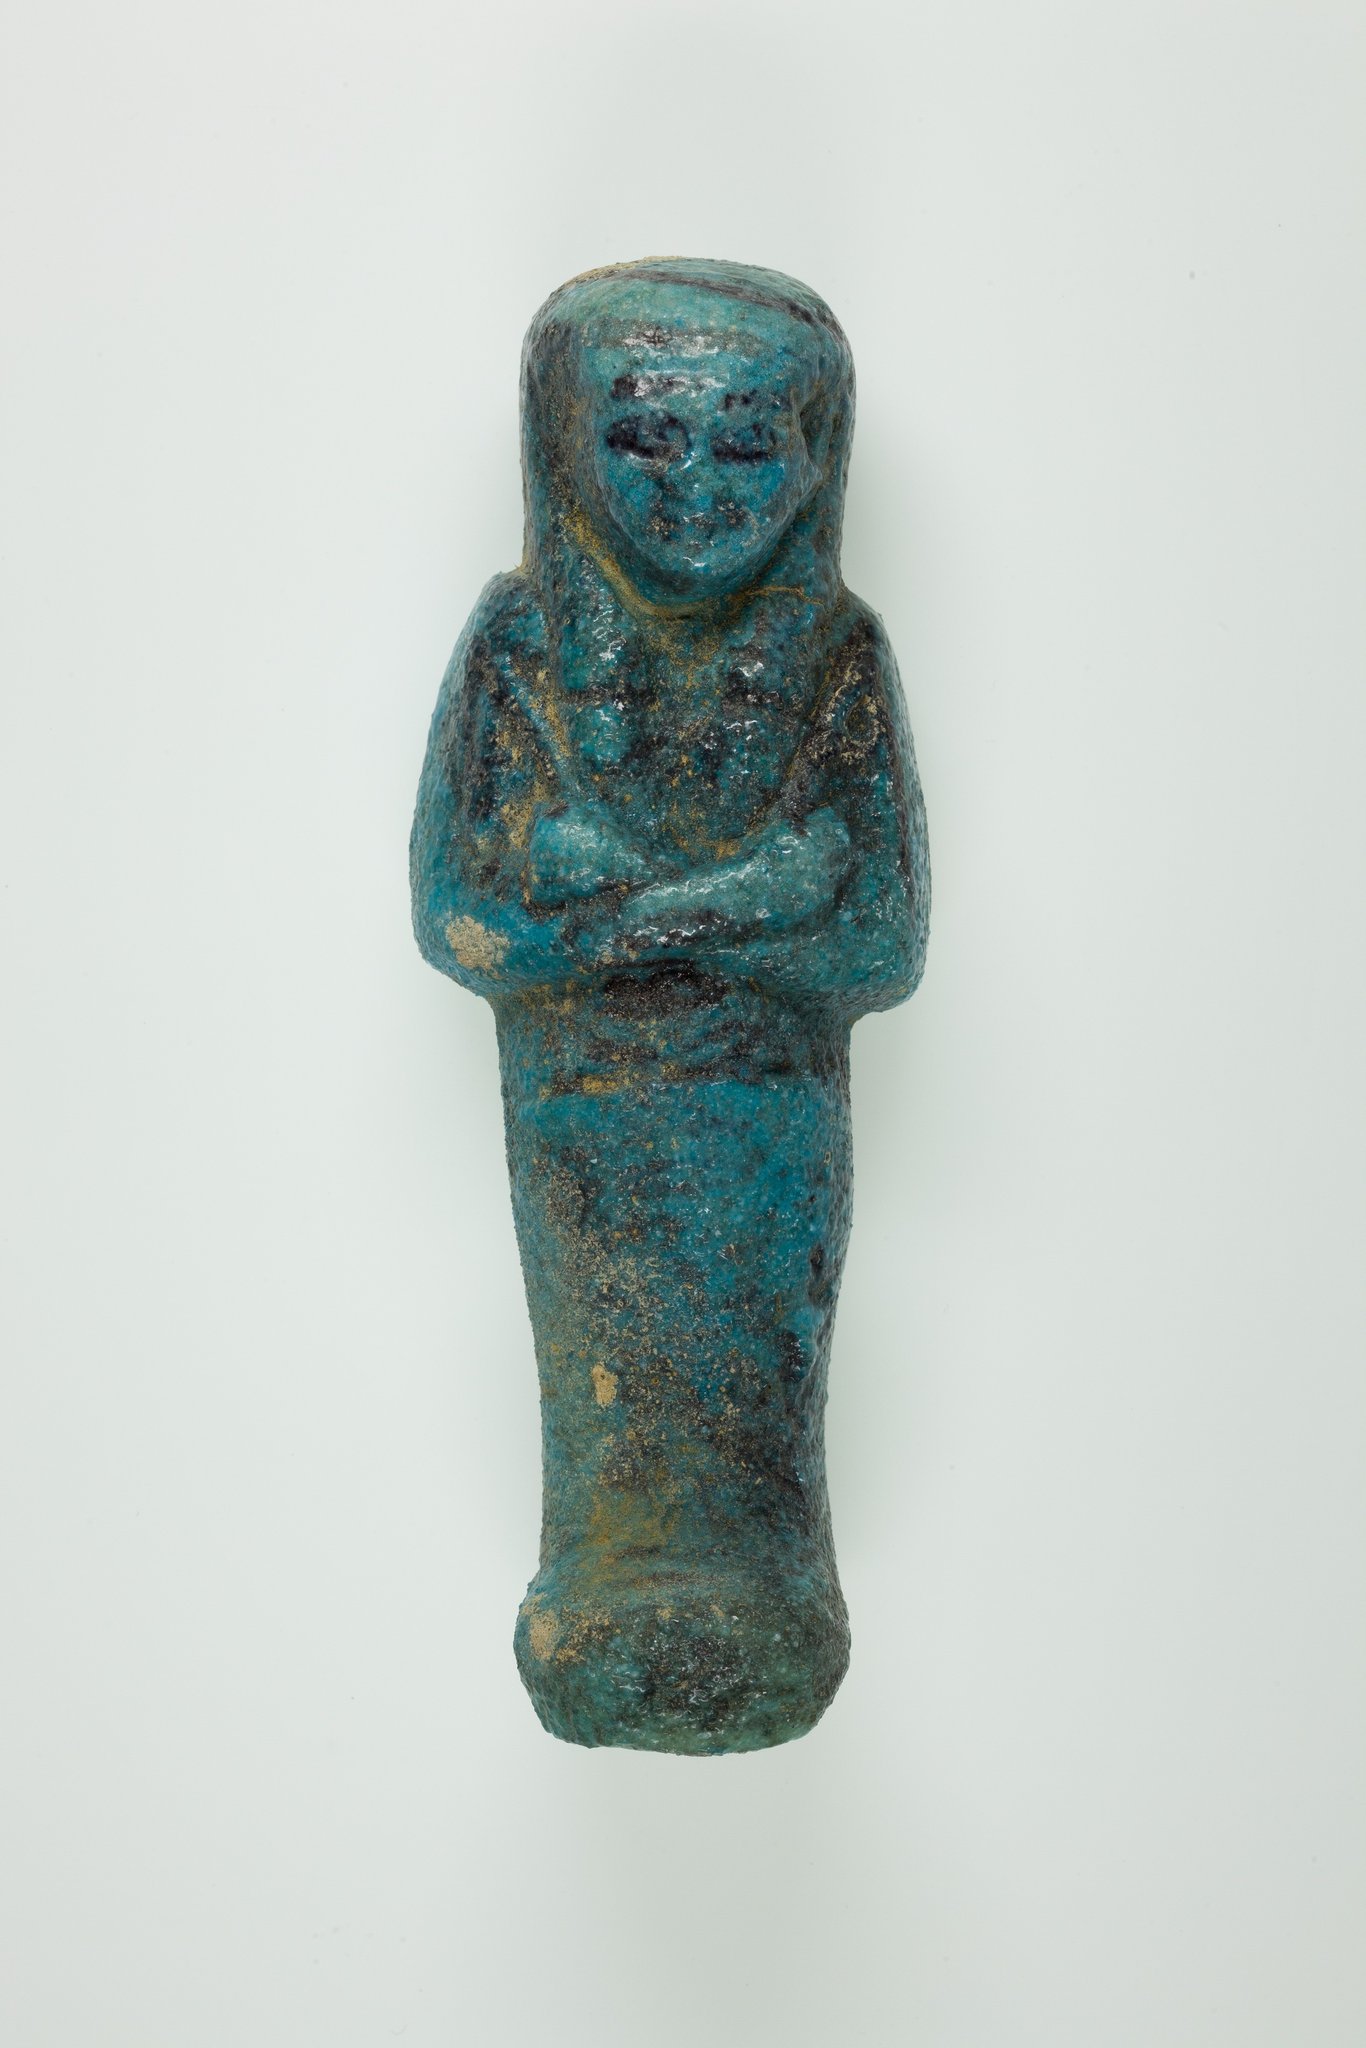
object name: worker shabti, henettawy c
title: Worker Shabti of Henettawy (C), Daughter of Isetemkheb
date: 990-970 BCE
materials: faience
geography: egypt